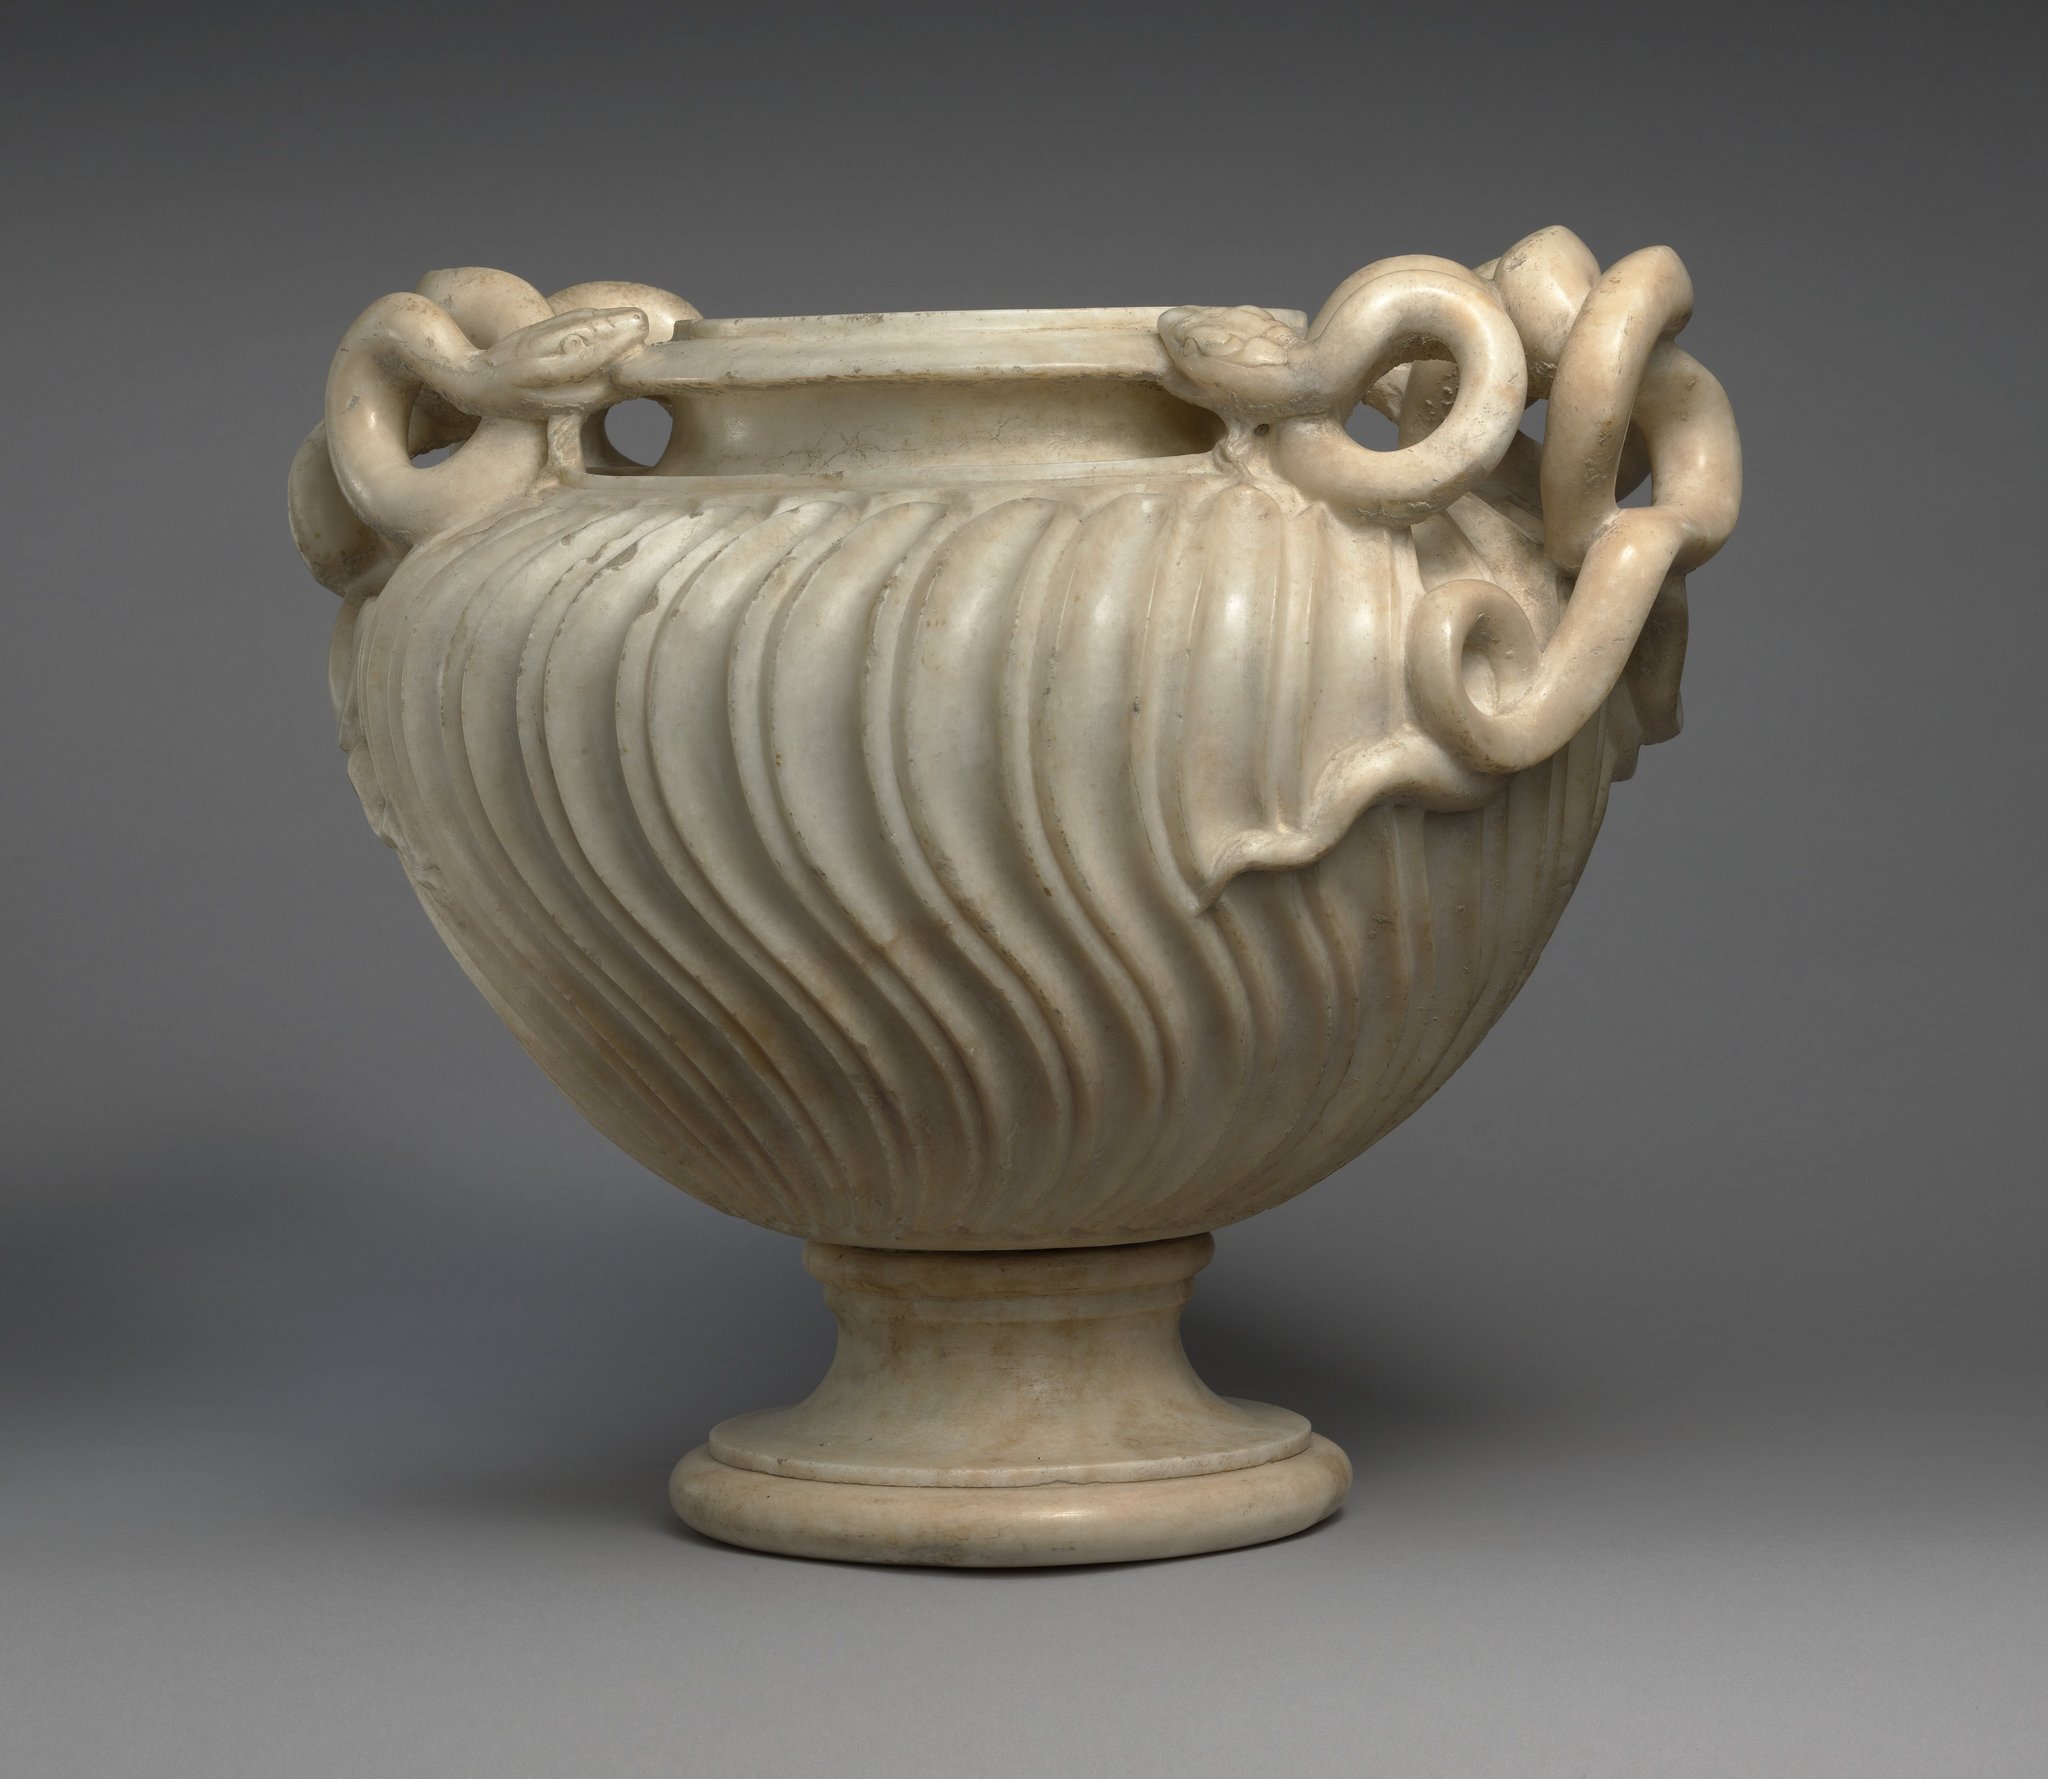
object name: strigilated vase with snake handle and lid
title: Marble strigilated vase with snake handles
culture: roman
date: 151-200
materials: marble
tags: snakes